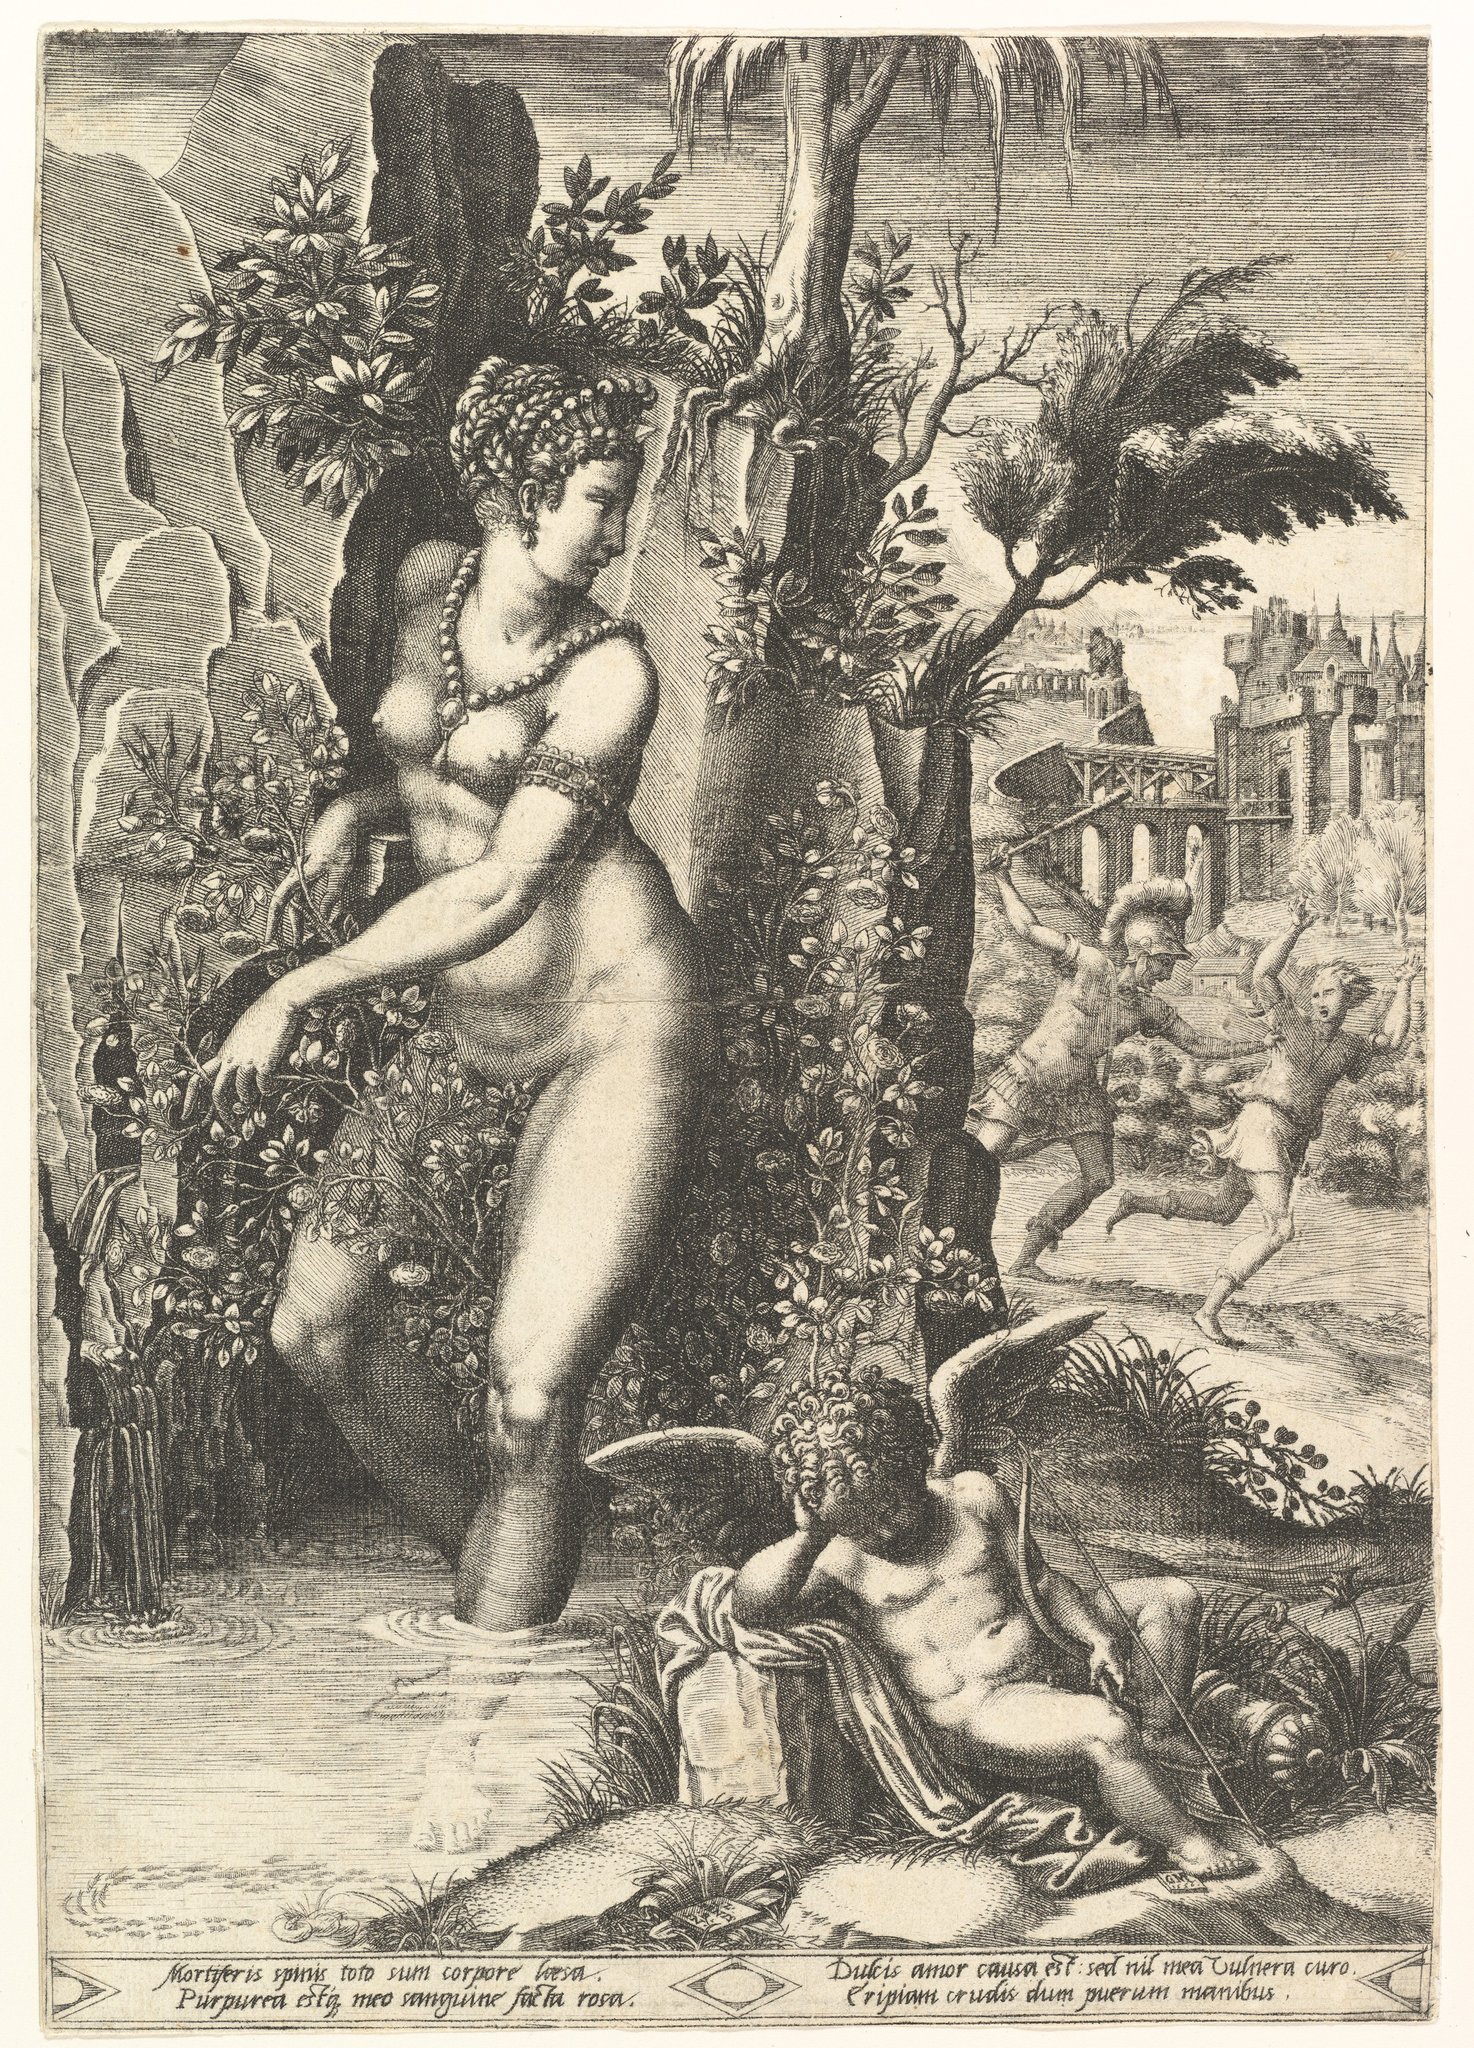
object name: print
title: Venus pricked by the thorns on a rose bush, in the background Mars chasing Adonis, in the foreground winged cupid resting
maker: giorgio ghisi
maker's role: artist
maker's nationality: italian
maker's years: 1515-1582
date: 1556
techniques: engraving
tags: cupid,adonis,mars,venus,trees